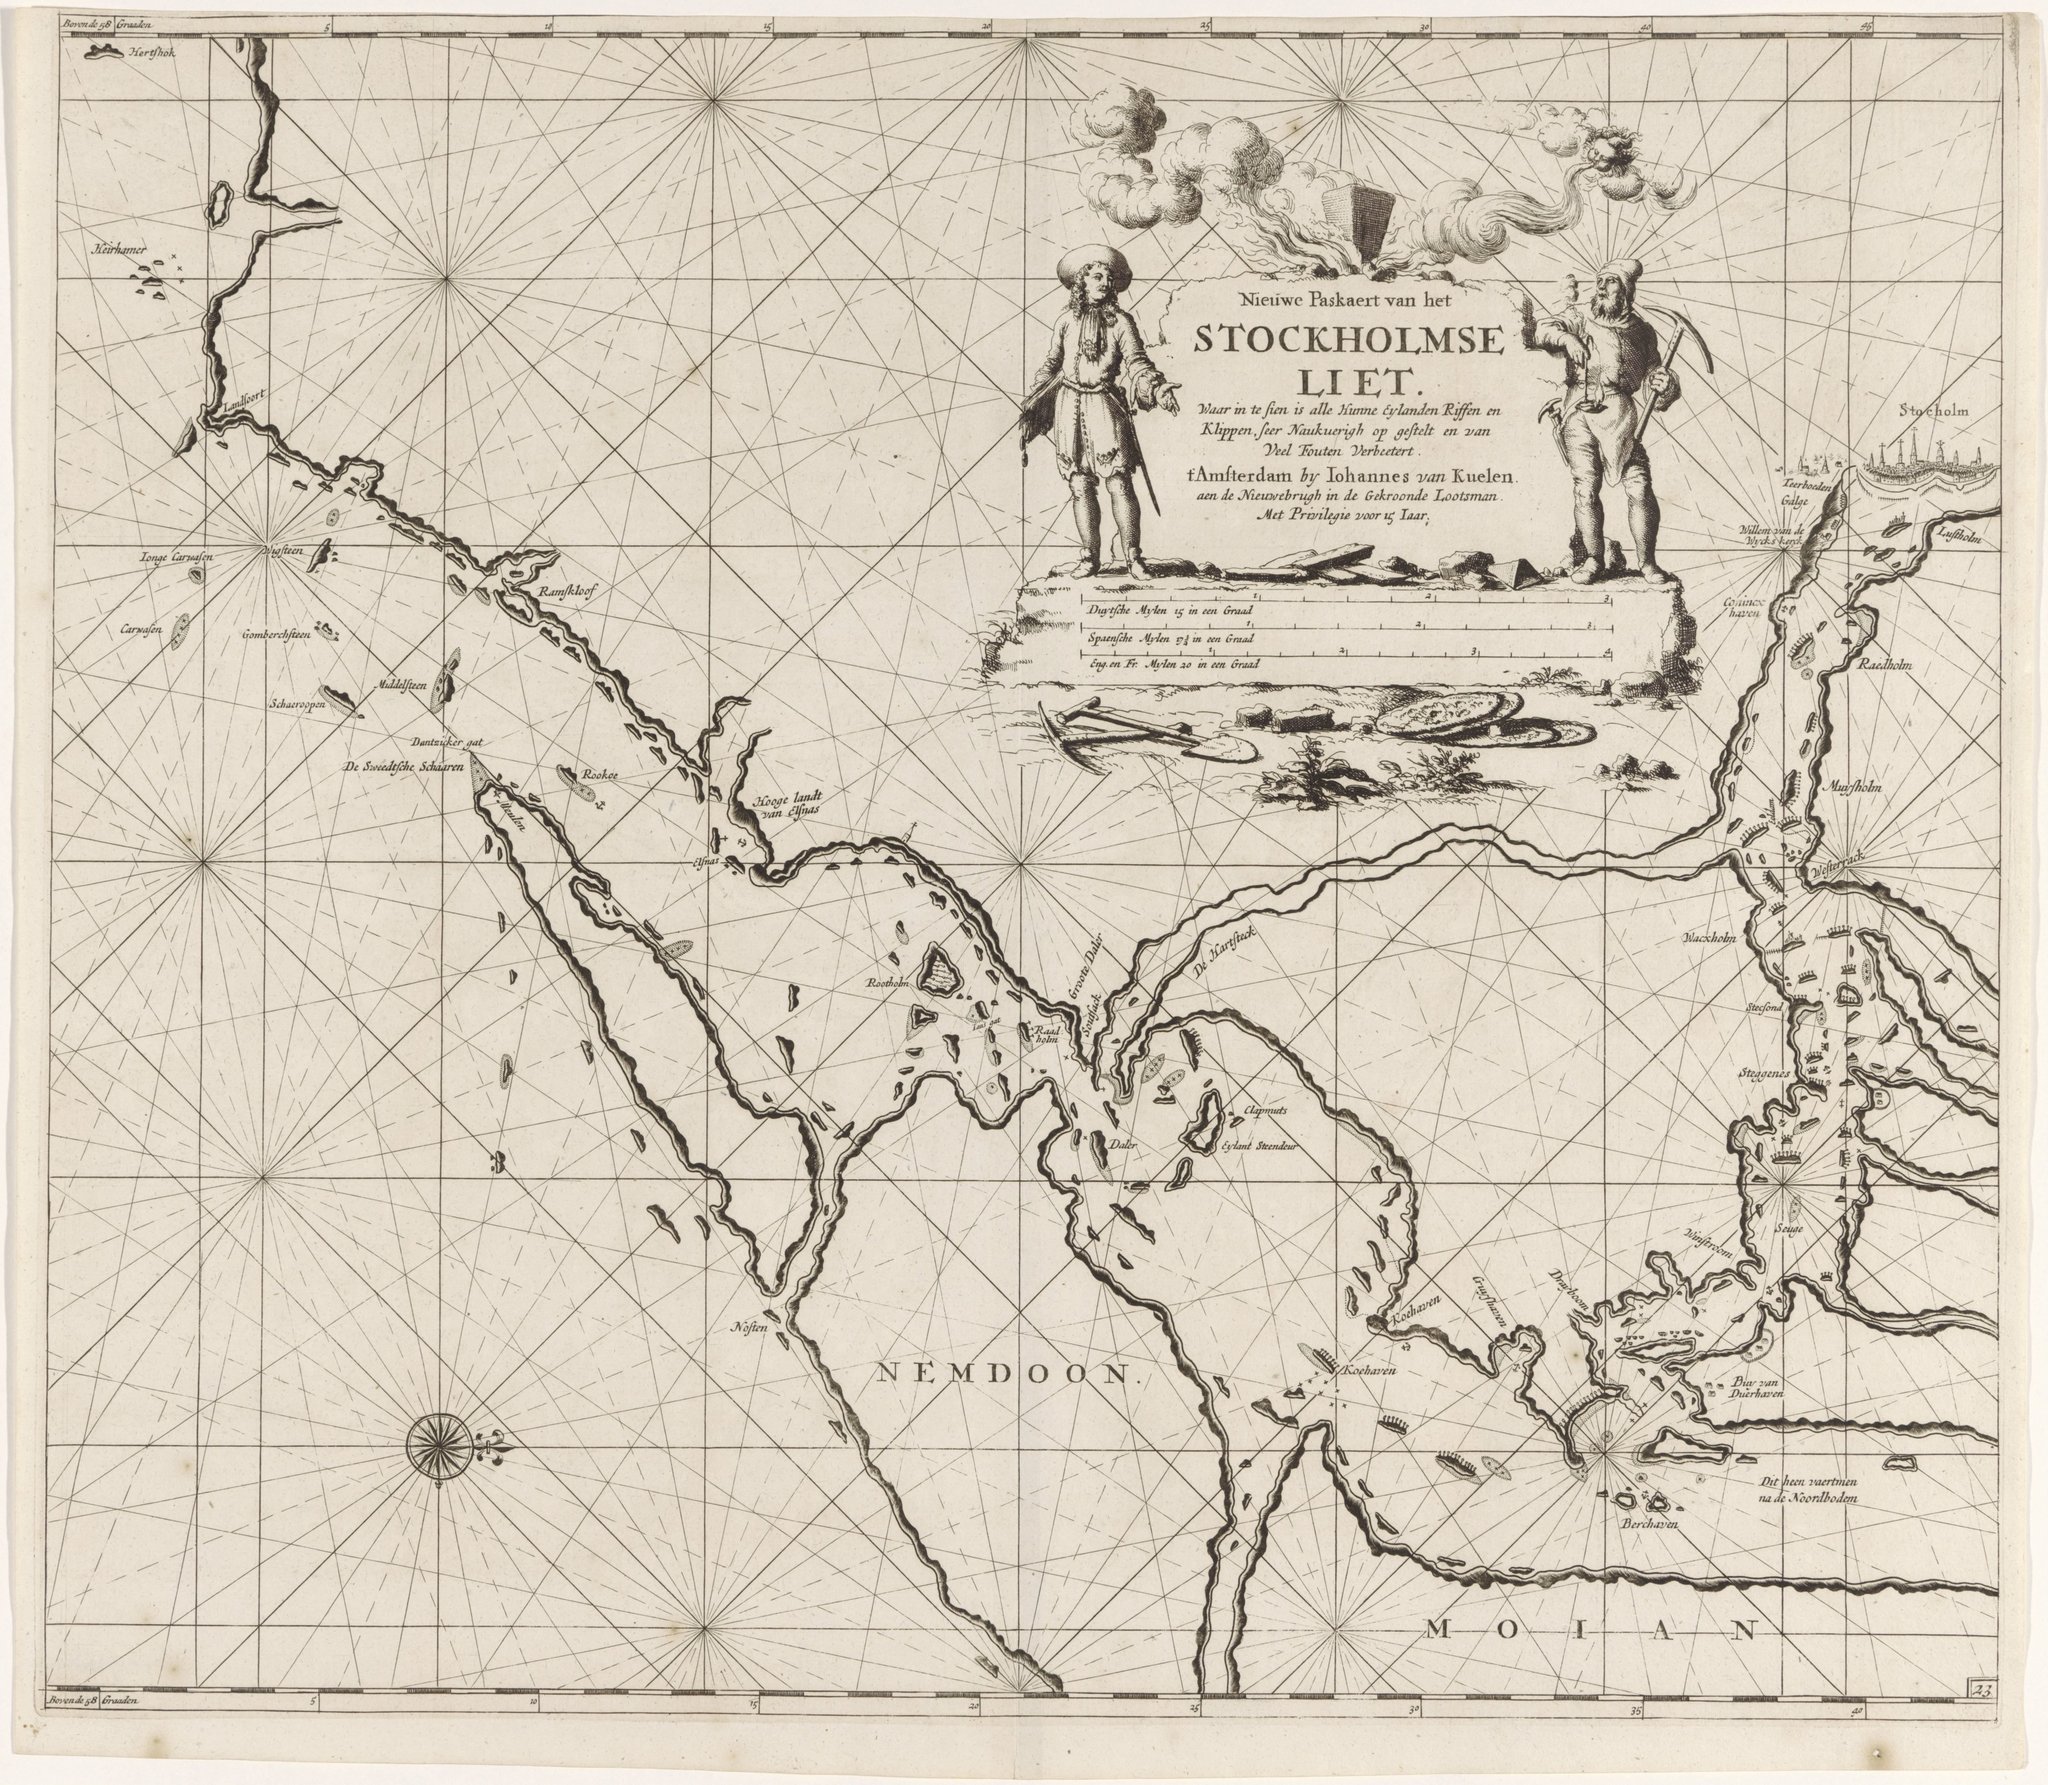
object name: print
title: Kaart van de wateren in de omgeving van Stockholm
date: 1681-1799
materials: paper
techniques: engraving, etching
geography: amsterdam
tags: wind as a human face, blowing with rounded cheeks, agricultural implements: spade, smith, blacksmith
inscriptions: collector's mark: Lugt 2228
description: Kaart van de wateren in de omgeving van Stockholm, met een kompasroos, het Noorden ligt rechts. Rechtsboven een cartouche met de titel, het adres van de uitgever en de schaalverdeling in Duitse, Spaanse en Engelse of Franse mijlen (schaal: c. 1:150.000). De titel wordt geflankeerd door een heer met een portefeuille en een mijnwerker. Boven de titel wordt een blok metaal verhit in een vuur, aangewakkerd door de wind.